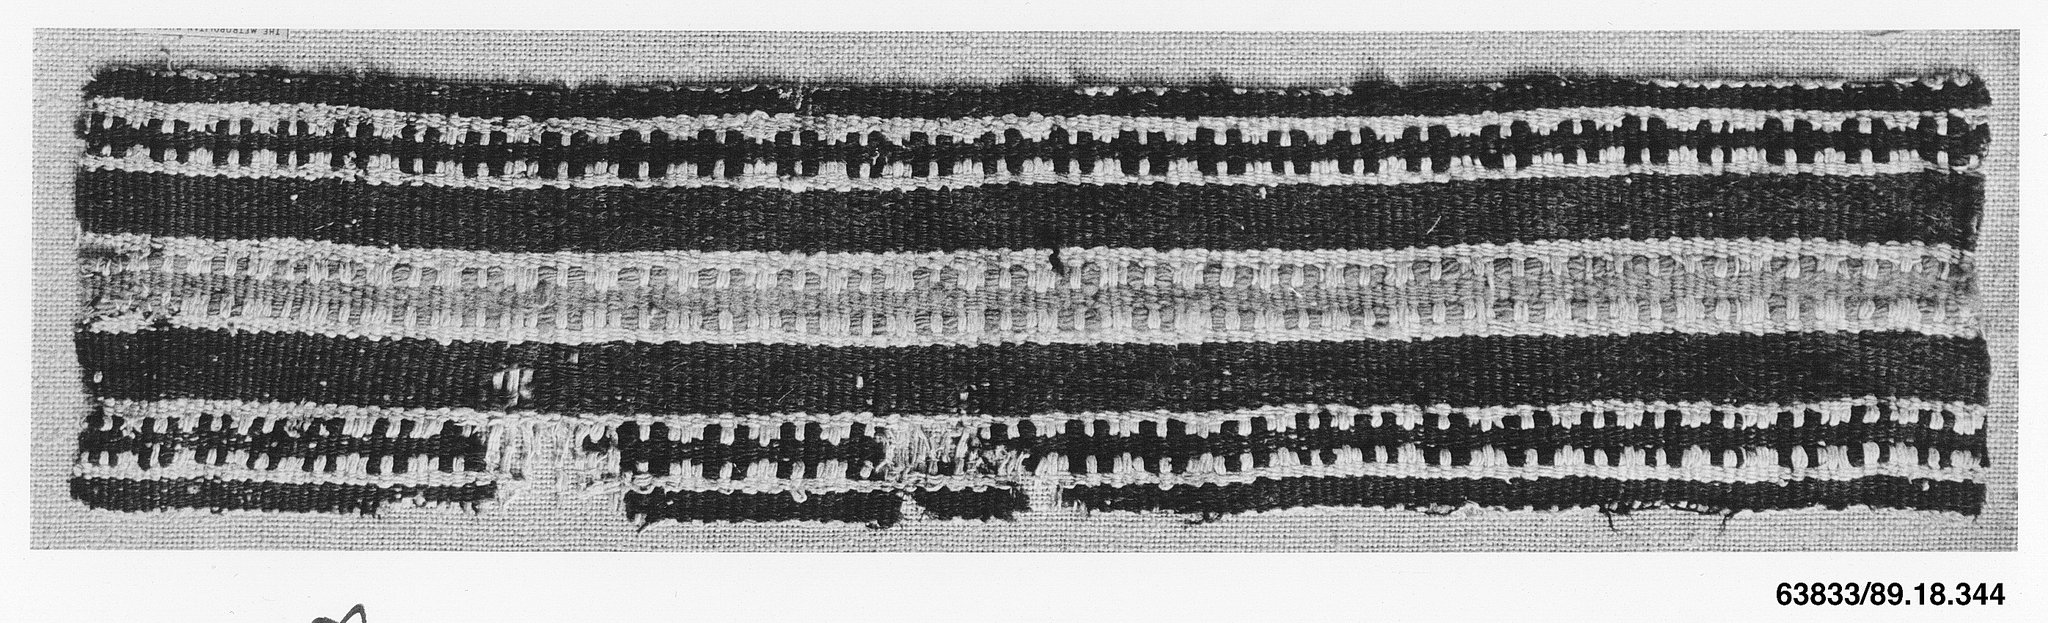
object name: textile fragment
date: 201-400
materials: linen, wool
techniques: weave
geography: egypt